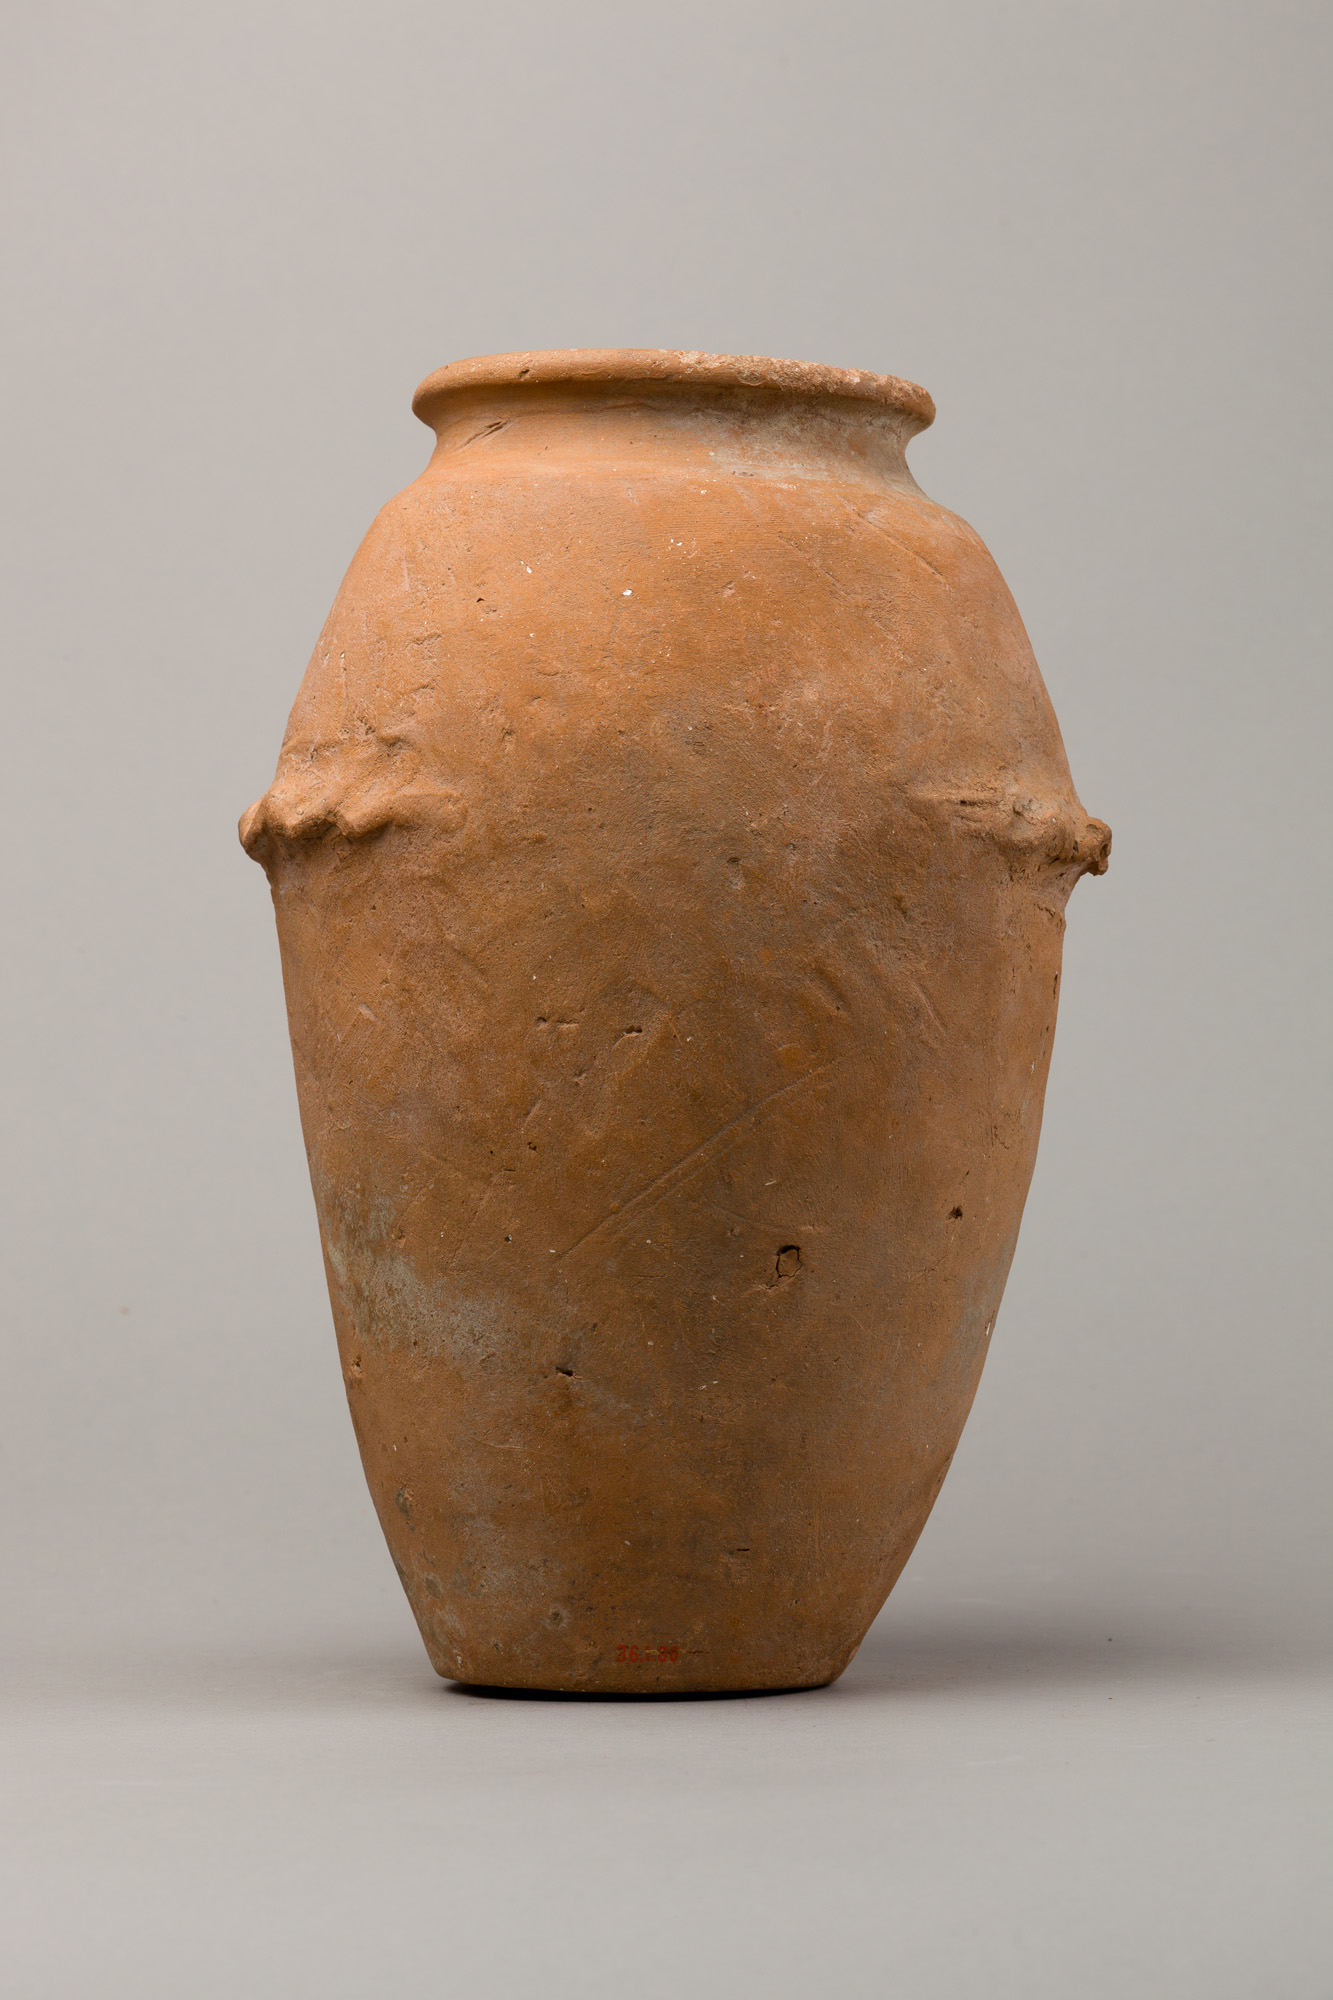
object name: jar, wavy handled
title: Wavy-handled jar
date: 3850-2960 BCE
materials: pottery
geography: egypt